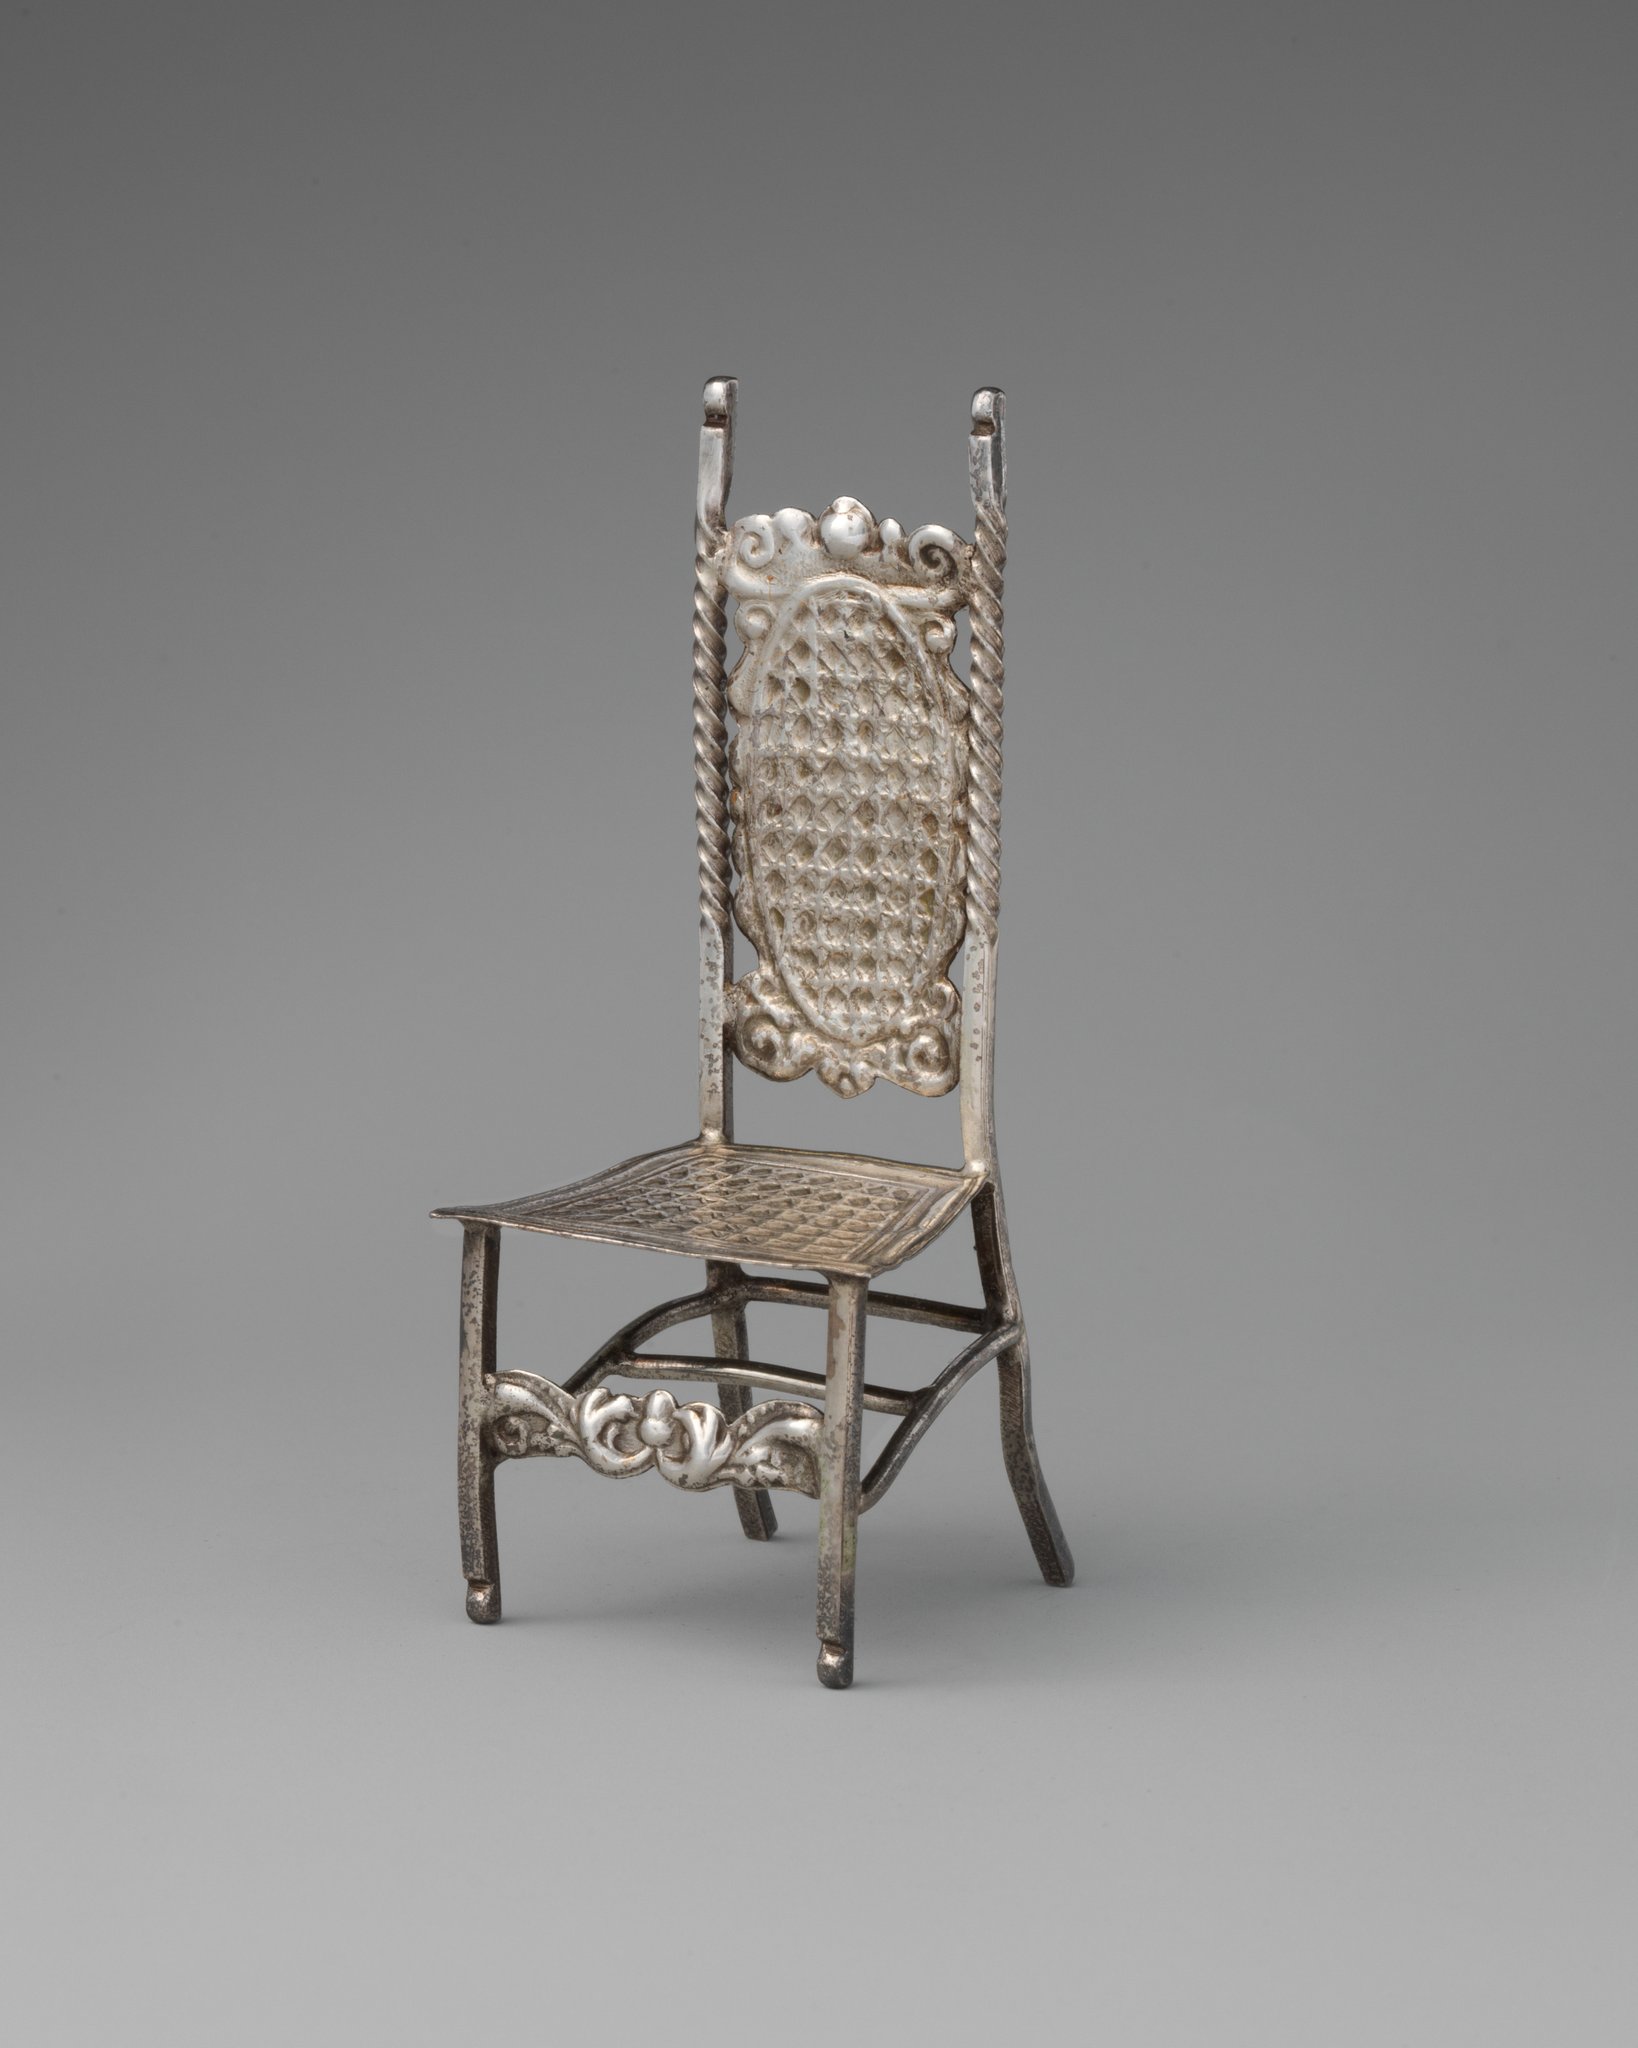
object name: side chair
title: Miniature side chair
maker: david clayton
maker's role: maker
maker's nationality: british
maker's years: 1659-1719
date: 1667-1733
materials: silver